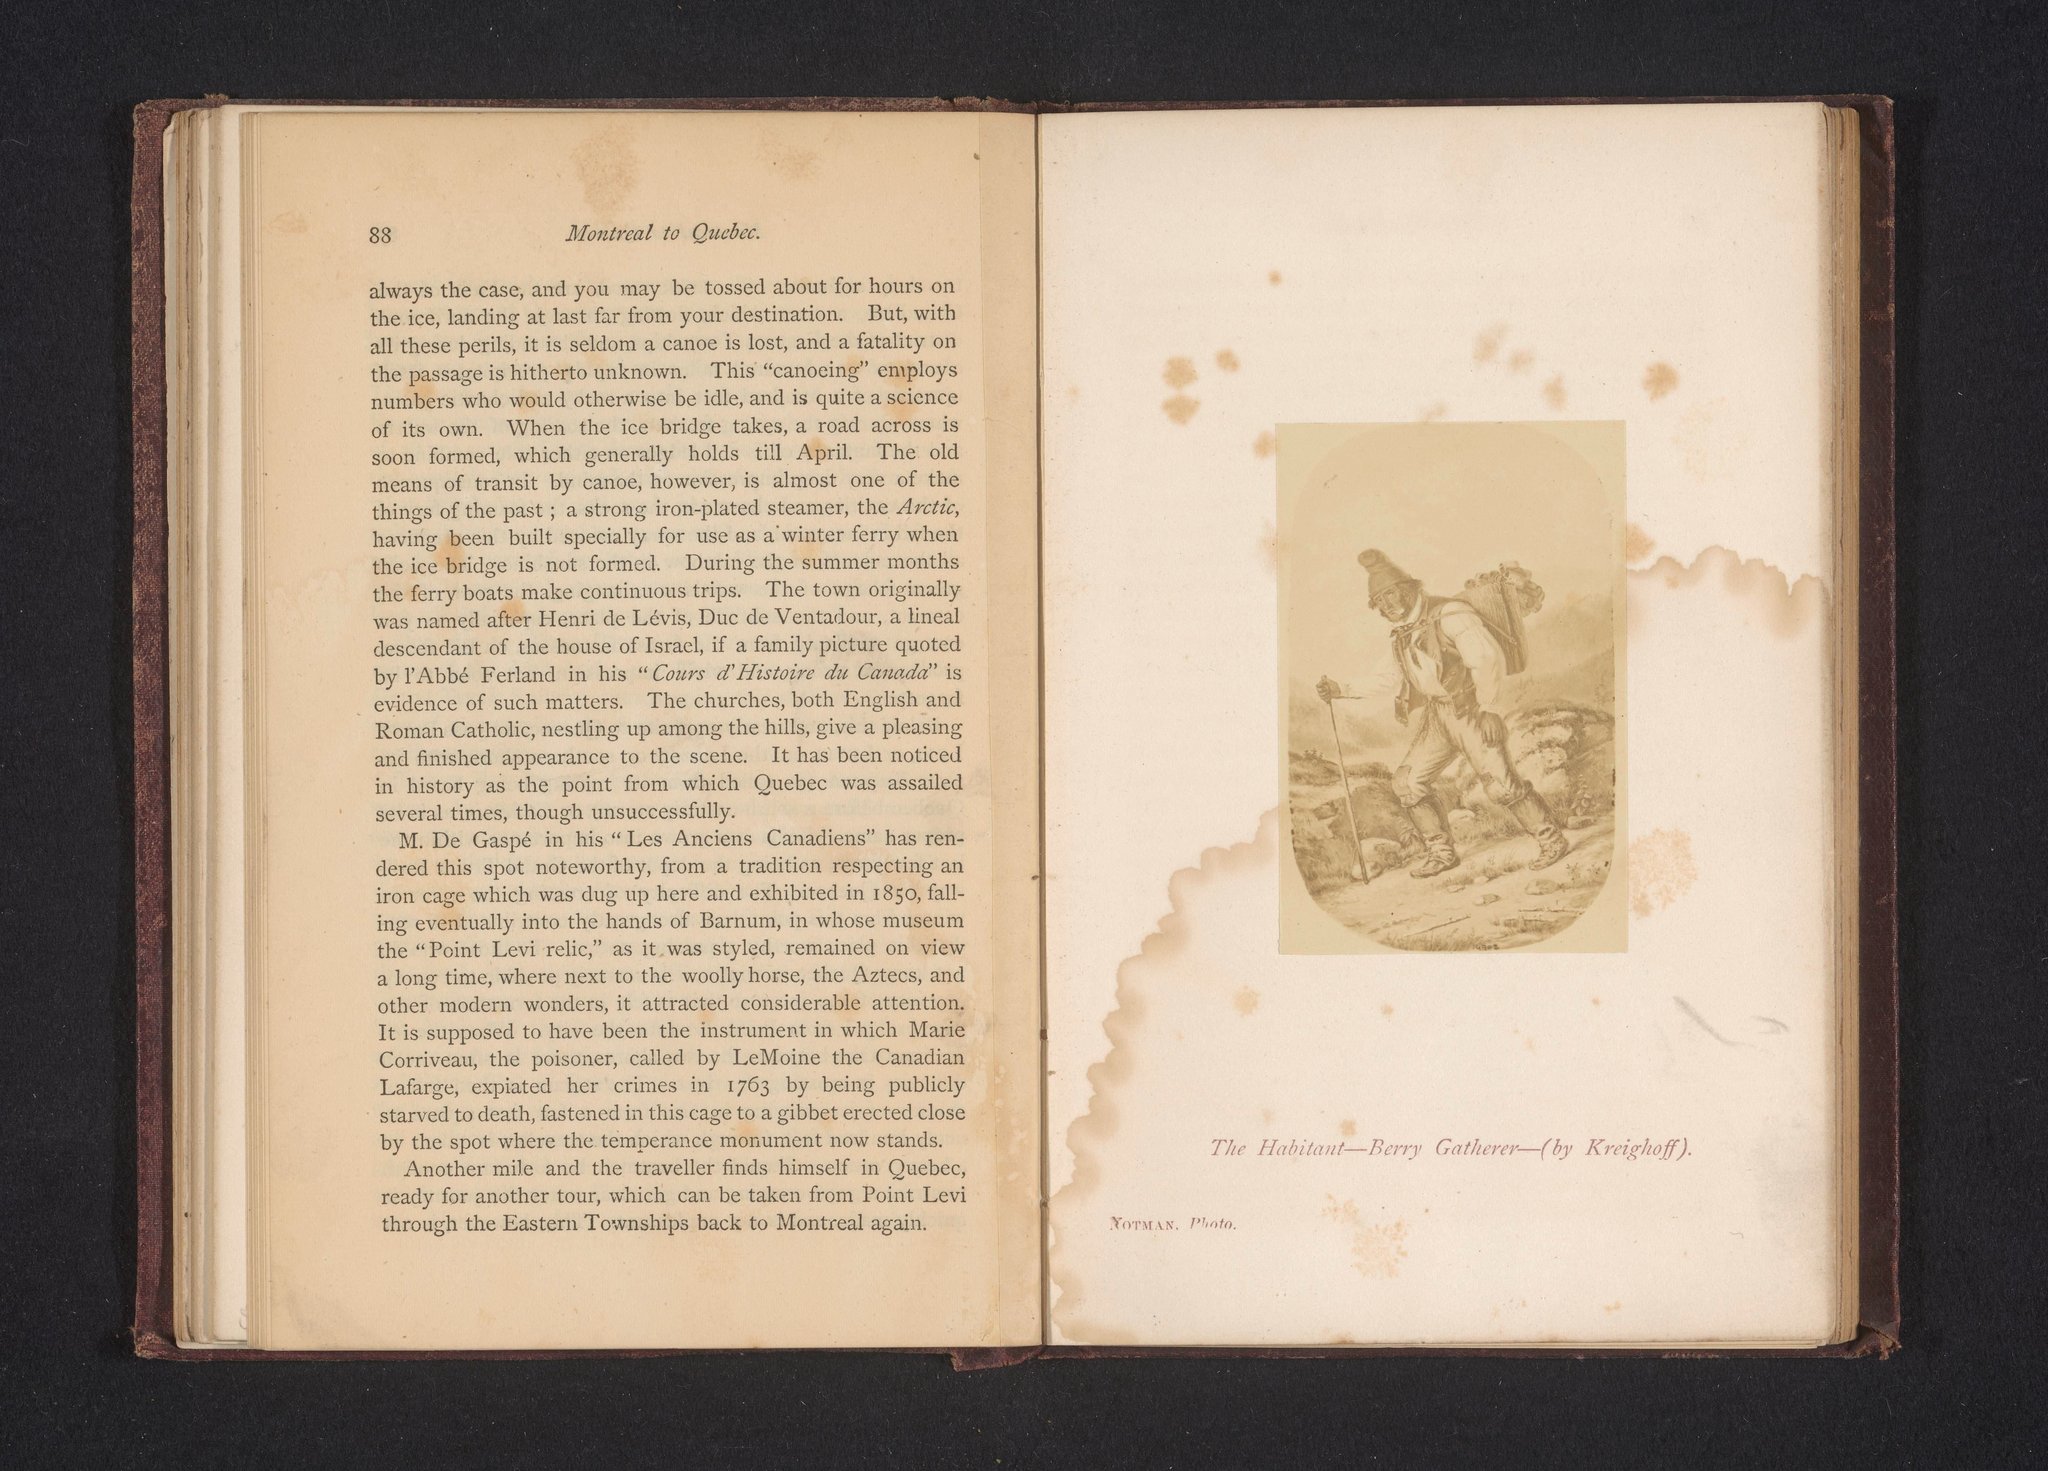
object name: page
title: The habitant-berry gatherer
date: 1856-1866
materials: photographic support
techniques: albumen print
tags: adult man, carrying something in basket, bag, rucksack, etc.